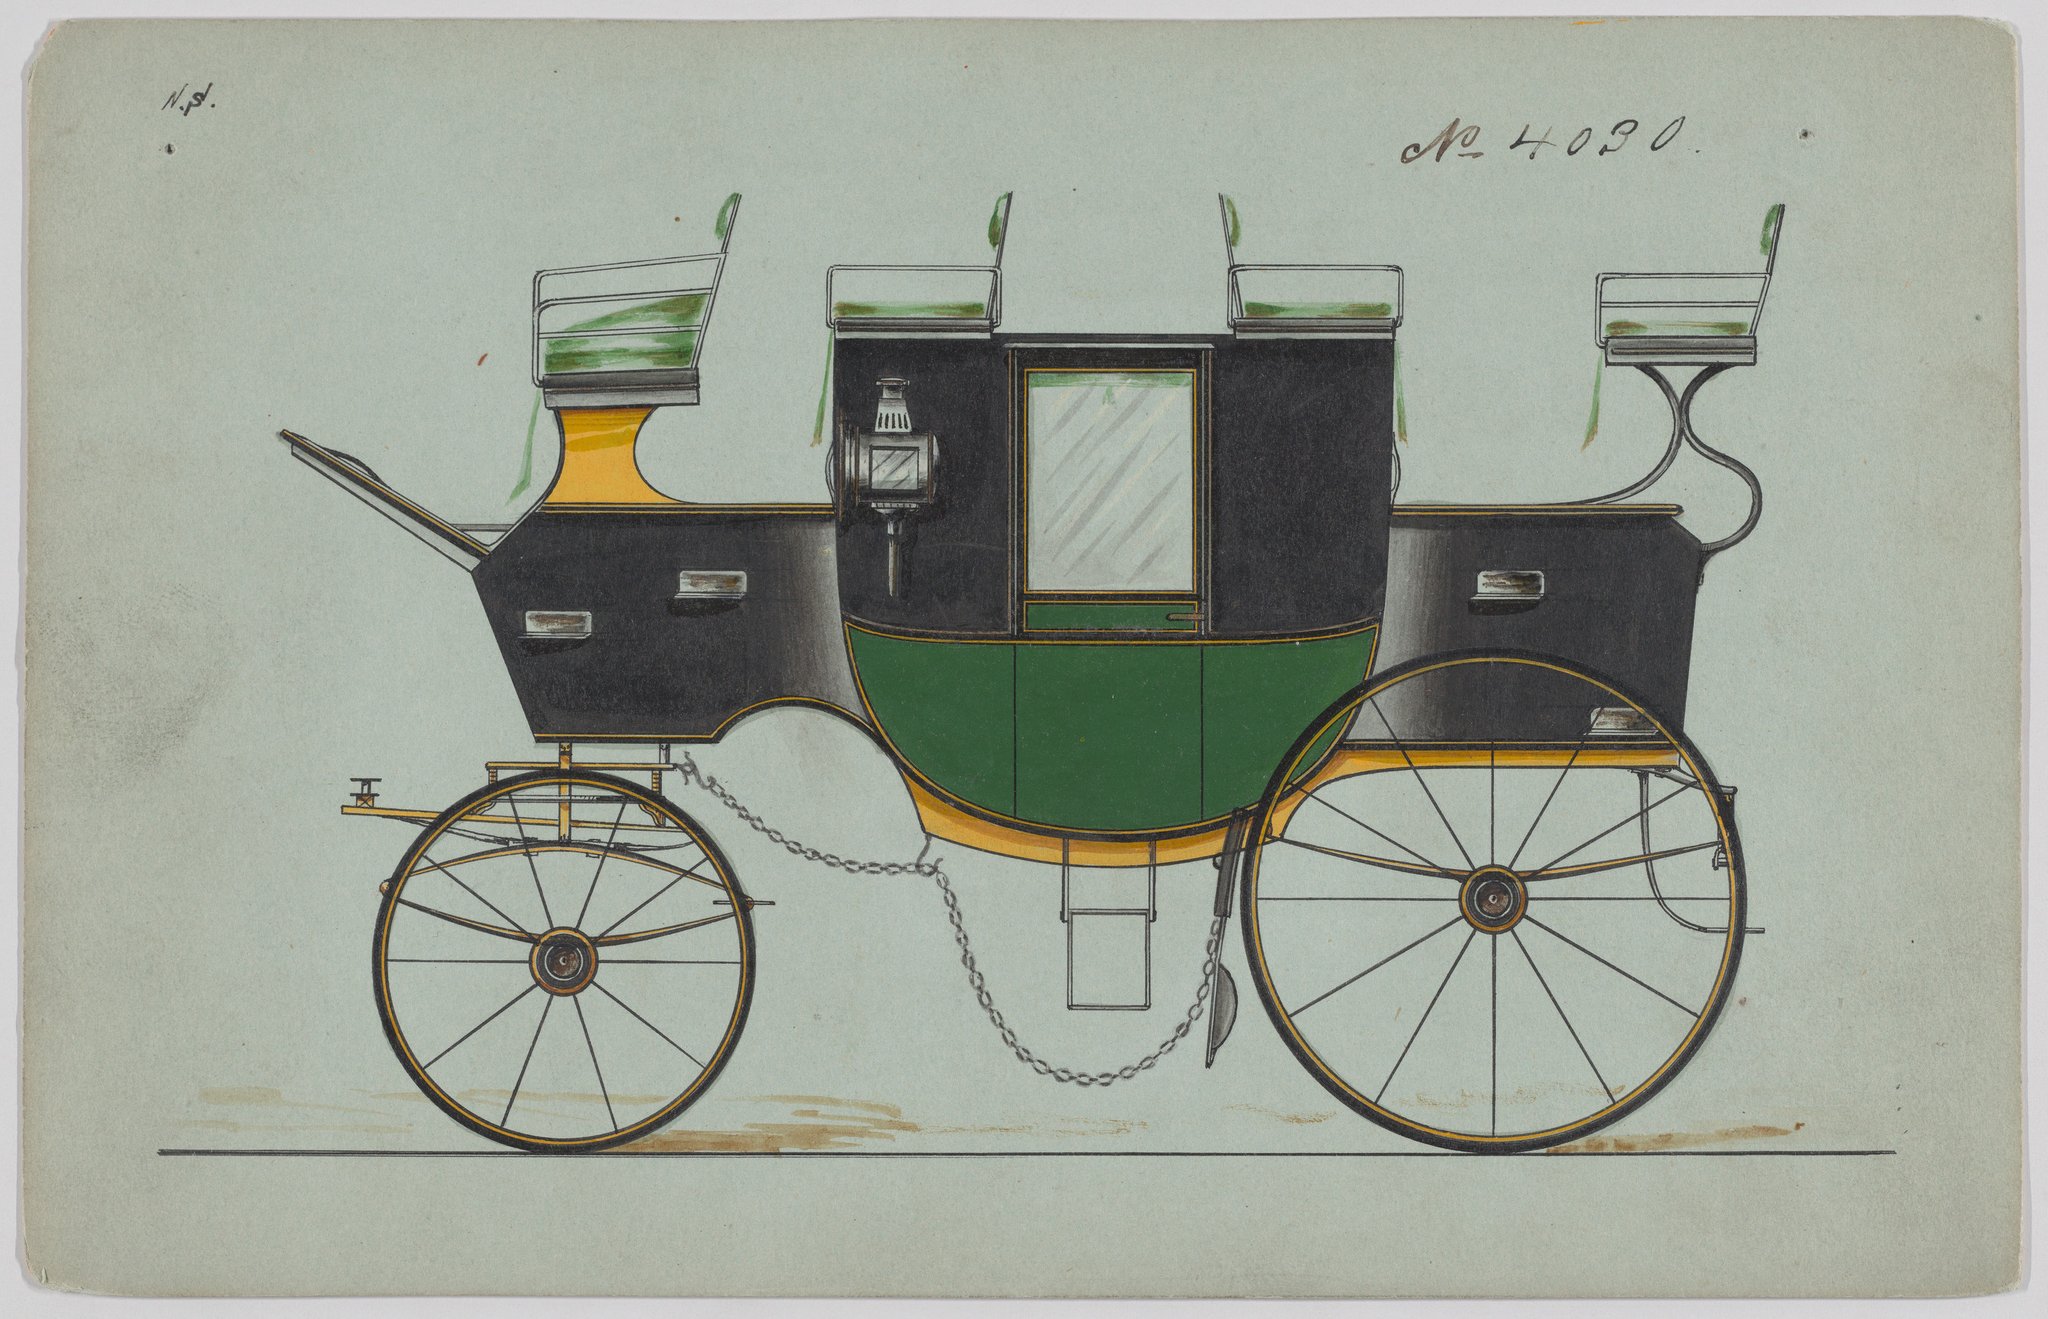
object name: drawing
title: Park Drag #4030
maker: brewster & co.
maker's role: manufacturer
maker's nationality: american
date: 1888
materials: gouache, gum arabic, ink, watercolor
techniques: pen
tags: carriages